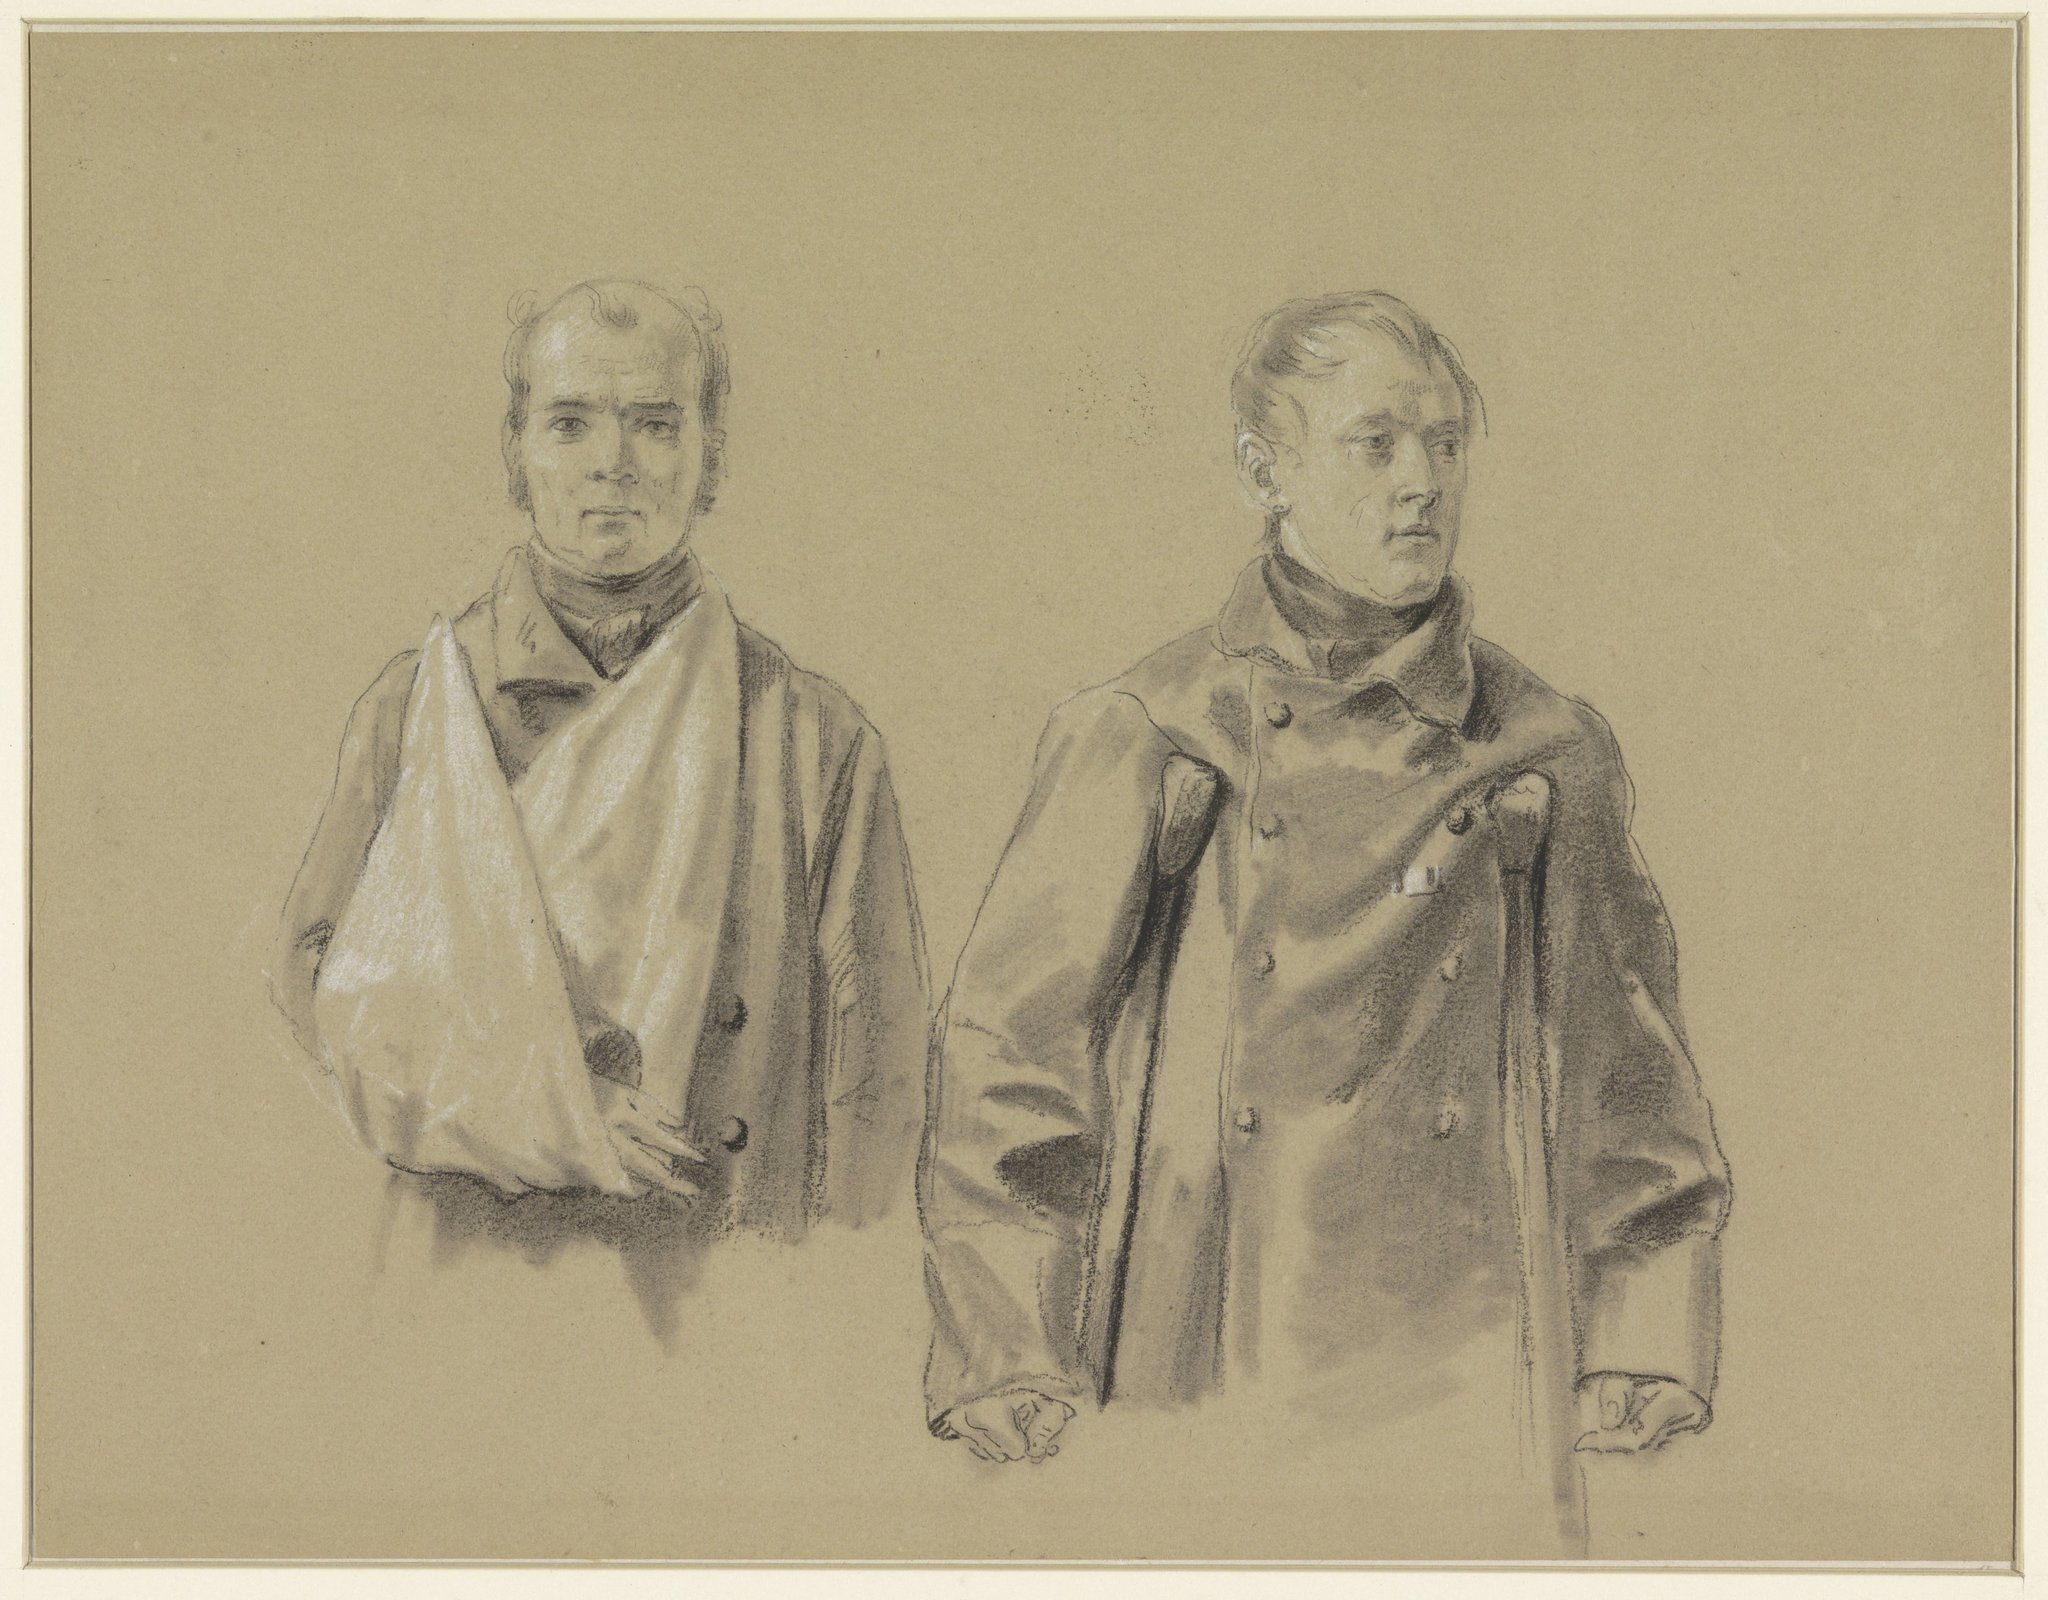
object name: drawing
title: Twee gewonde soldaten, de linker met zijn arm in een mitella, de rechter op krukken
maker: jacob joseph eeckhout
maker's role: draughtsman, print maker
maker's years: 1793-1861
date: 1803-1861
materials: chalk, paper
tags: person with a physical disability, disabled soldier